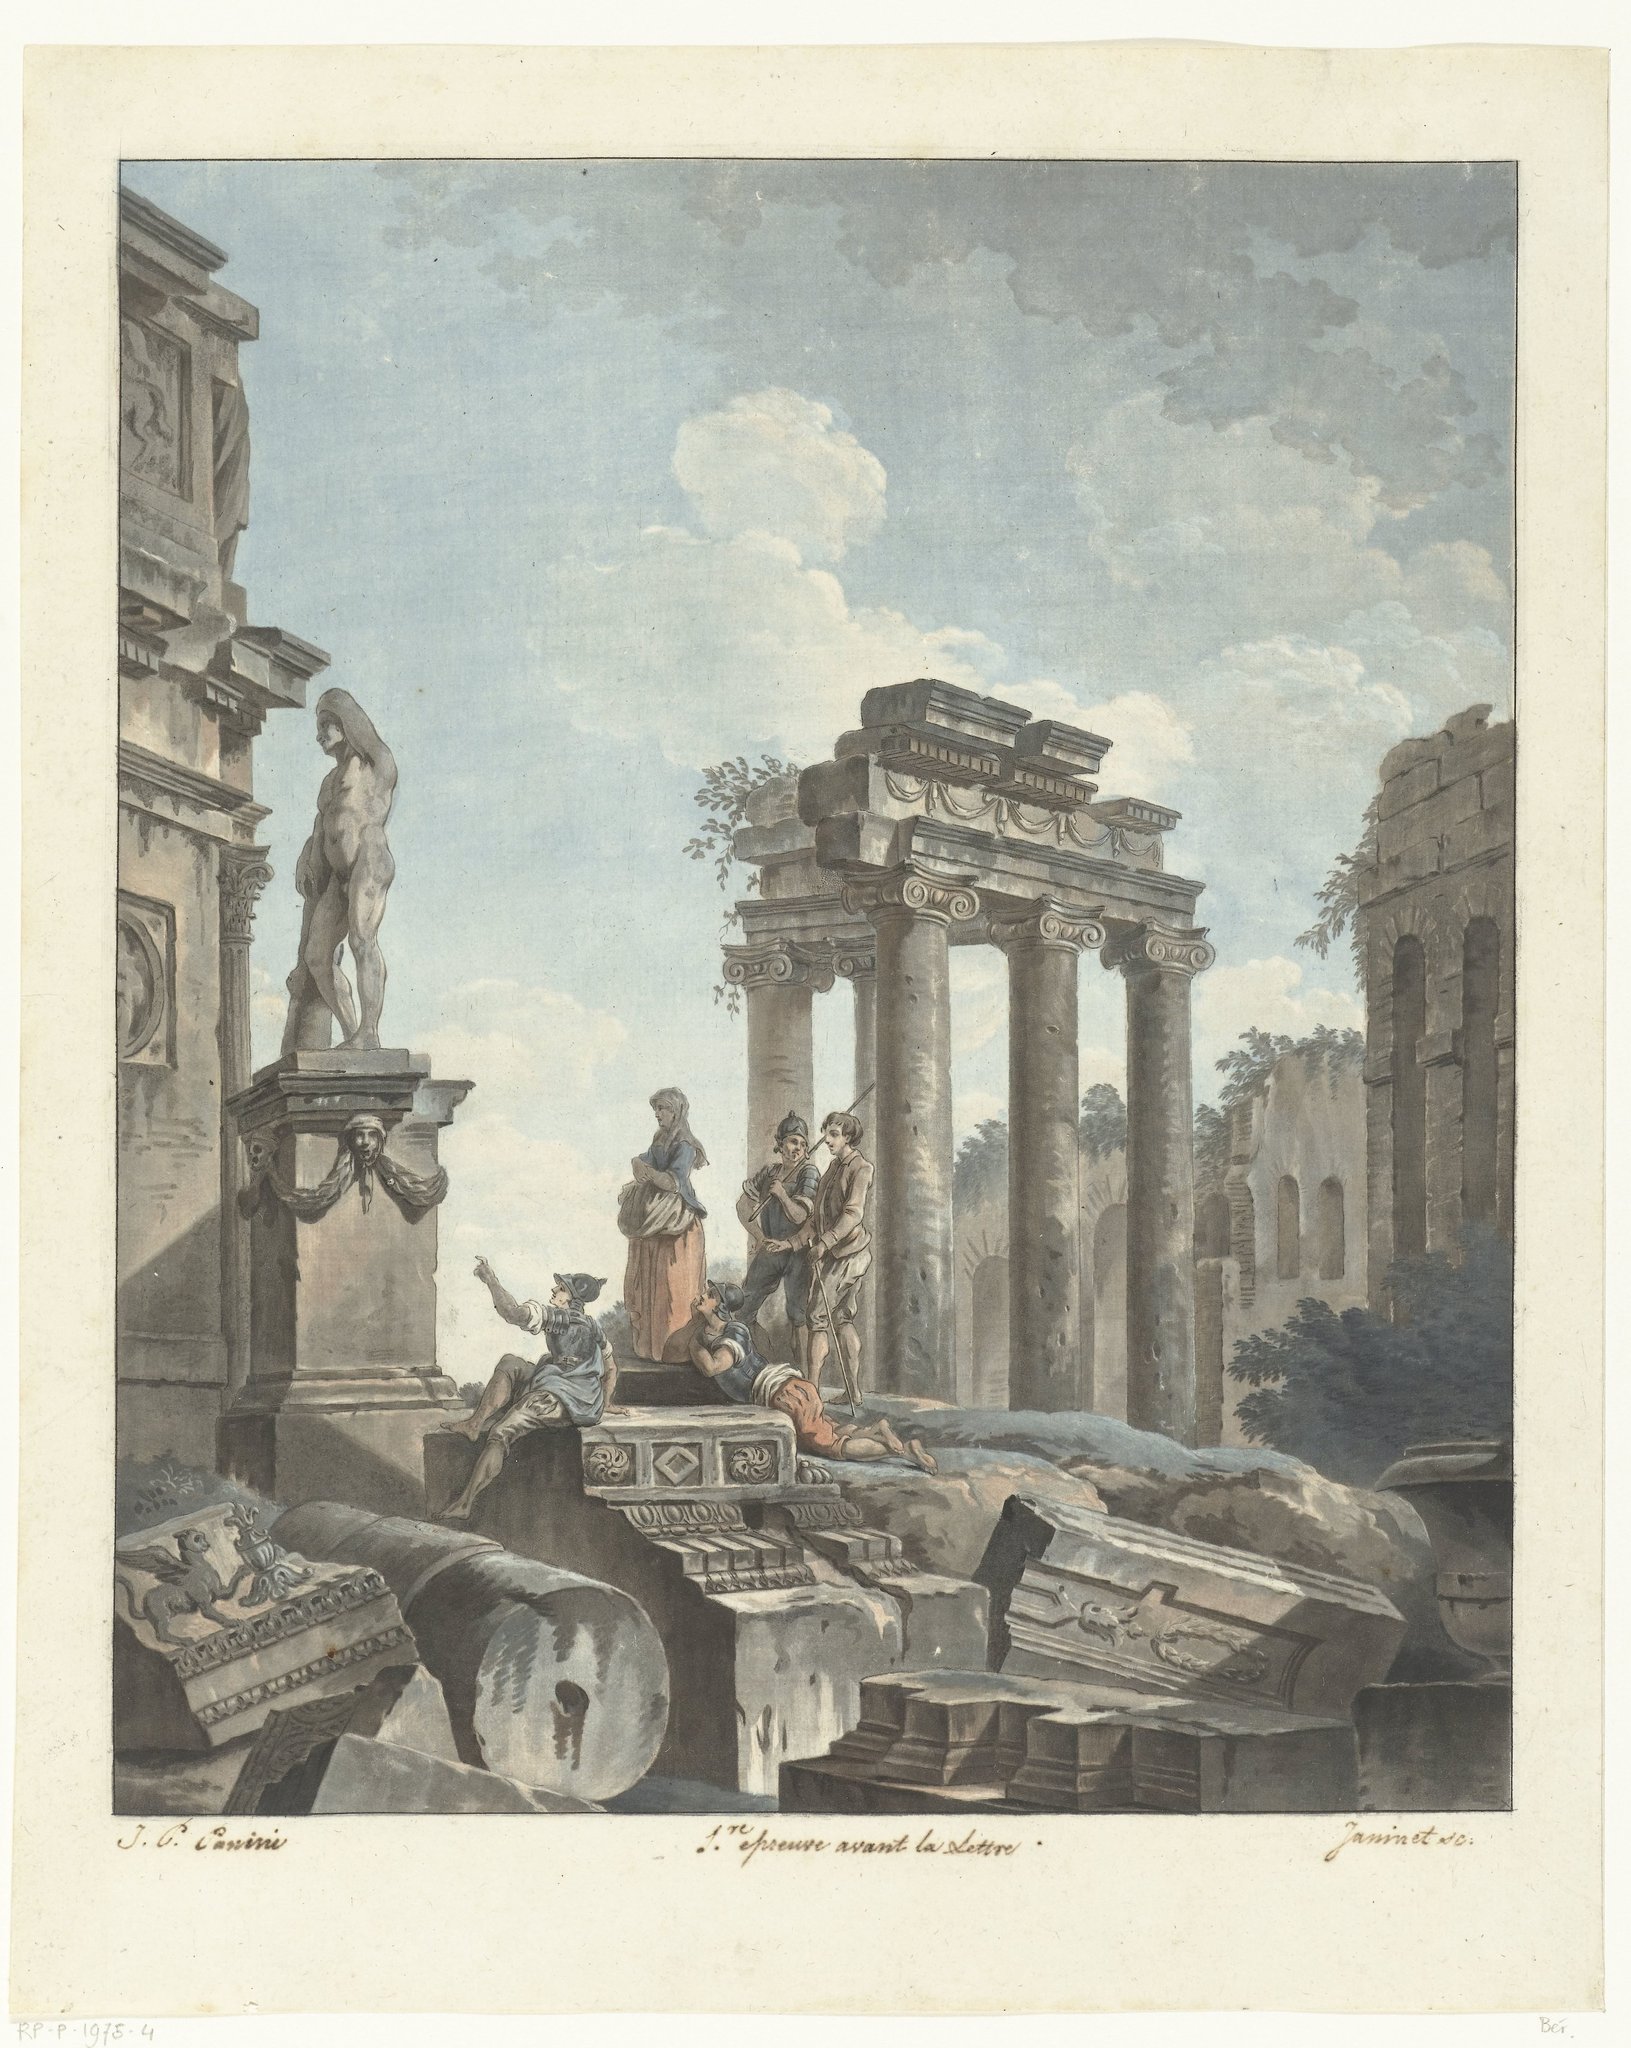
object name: print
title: Antieke ruïnes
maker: jean françois janinet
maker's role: print maker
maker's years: 1752-1814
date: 1762-1798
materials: paper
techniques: color aquatint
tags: ruin of a building ~ architecture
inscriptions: collector's mark: Lugt 2228, inscription: ‘J.P. Panini 1re epreuve avant la lettre janinet sc.’, collector's mark: Lugt 2760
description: Ruïne van een tempel met vijf figuren en een standbeeld van Hercules